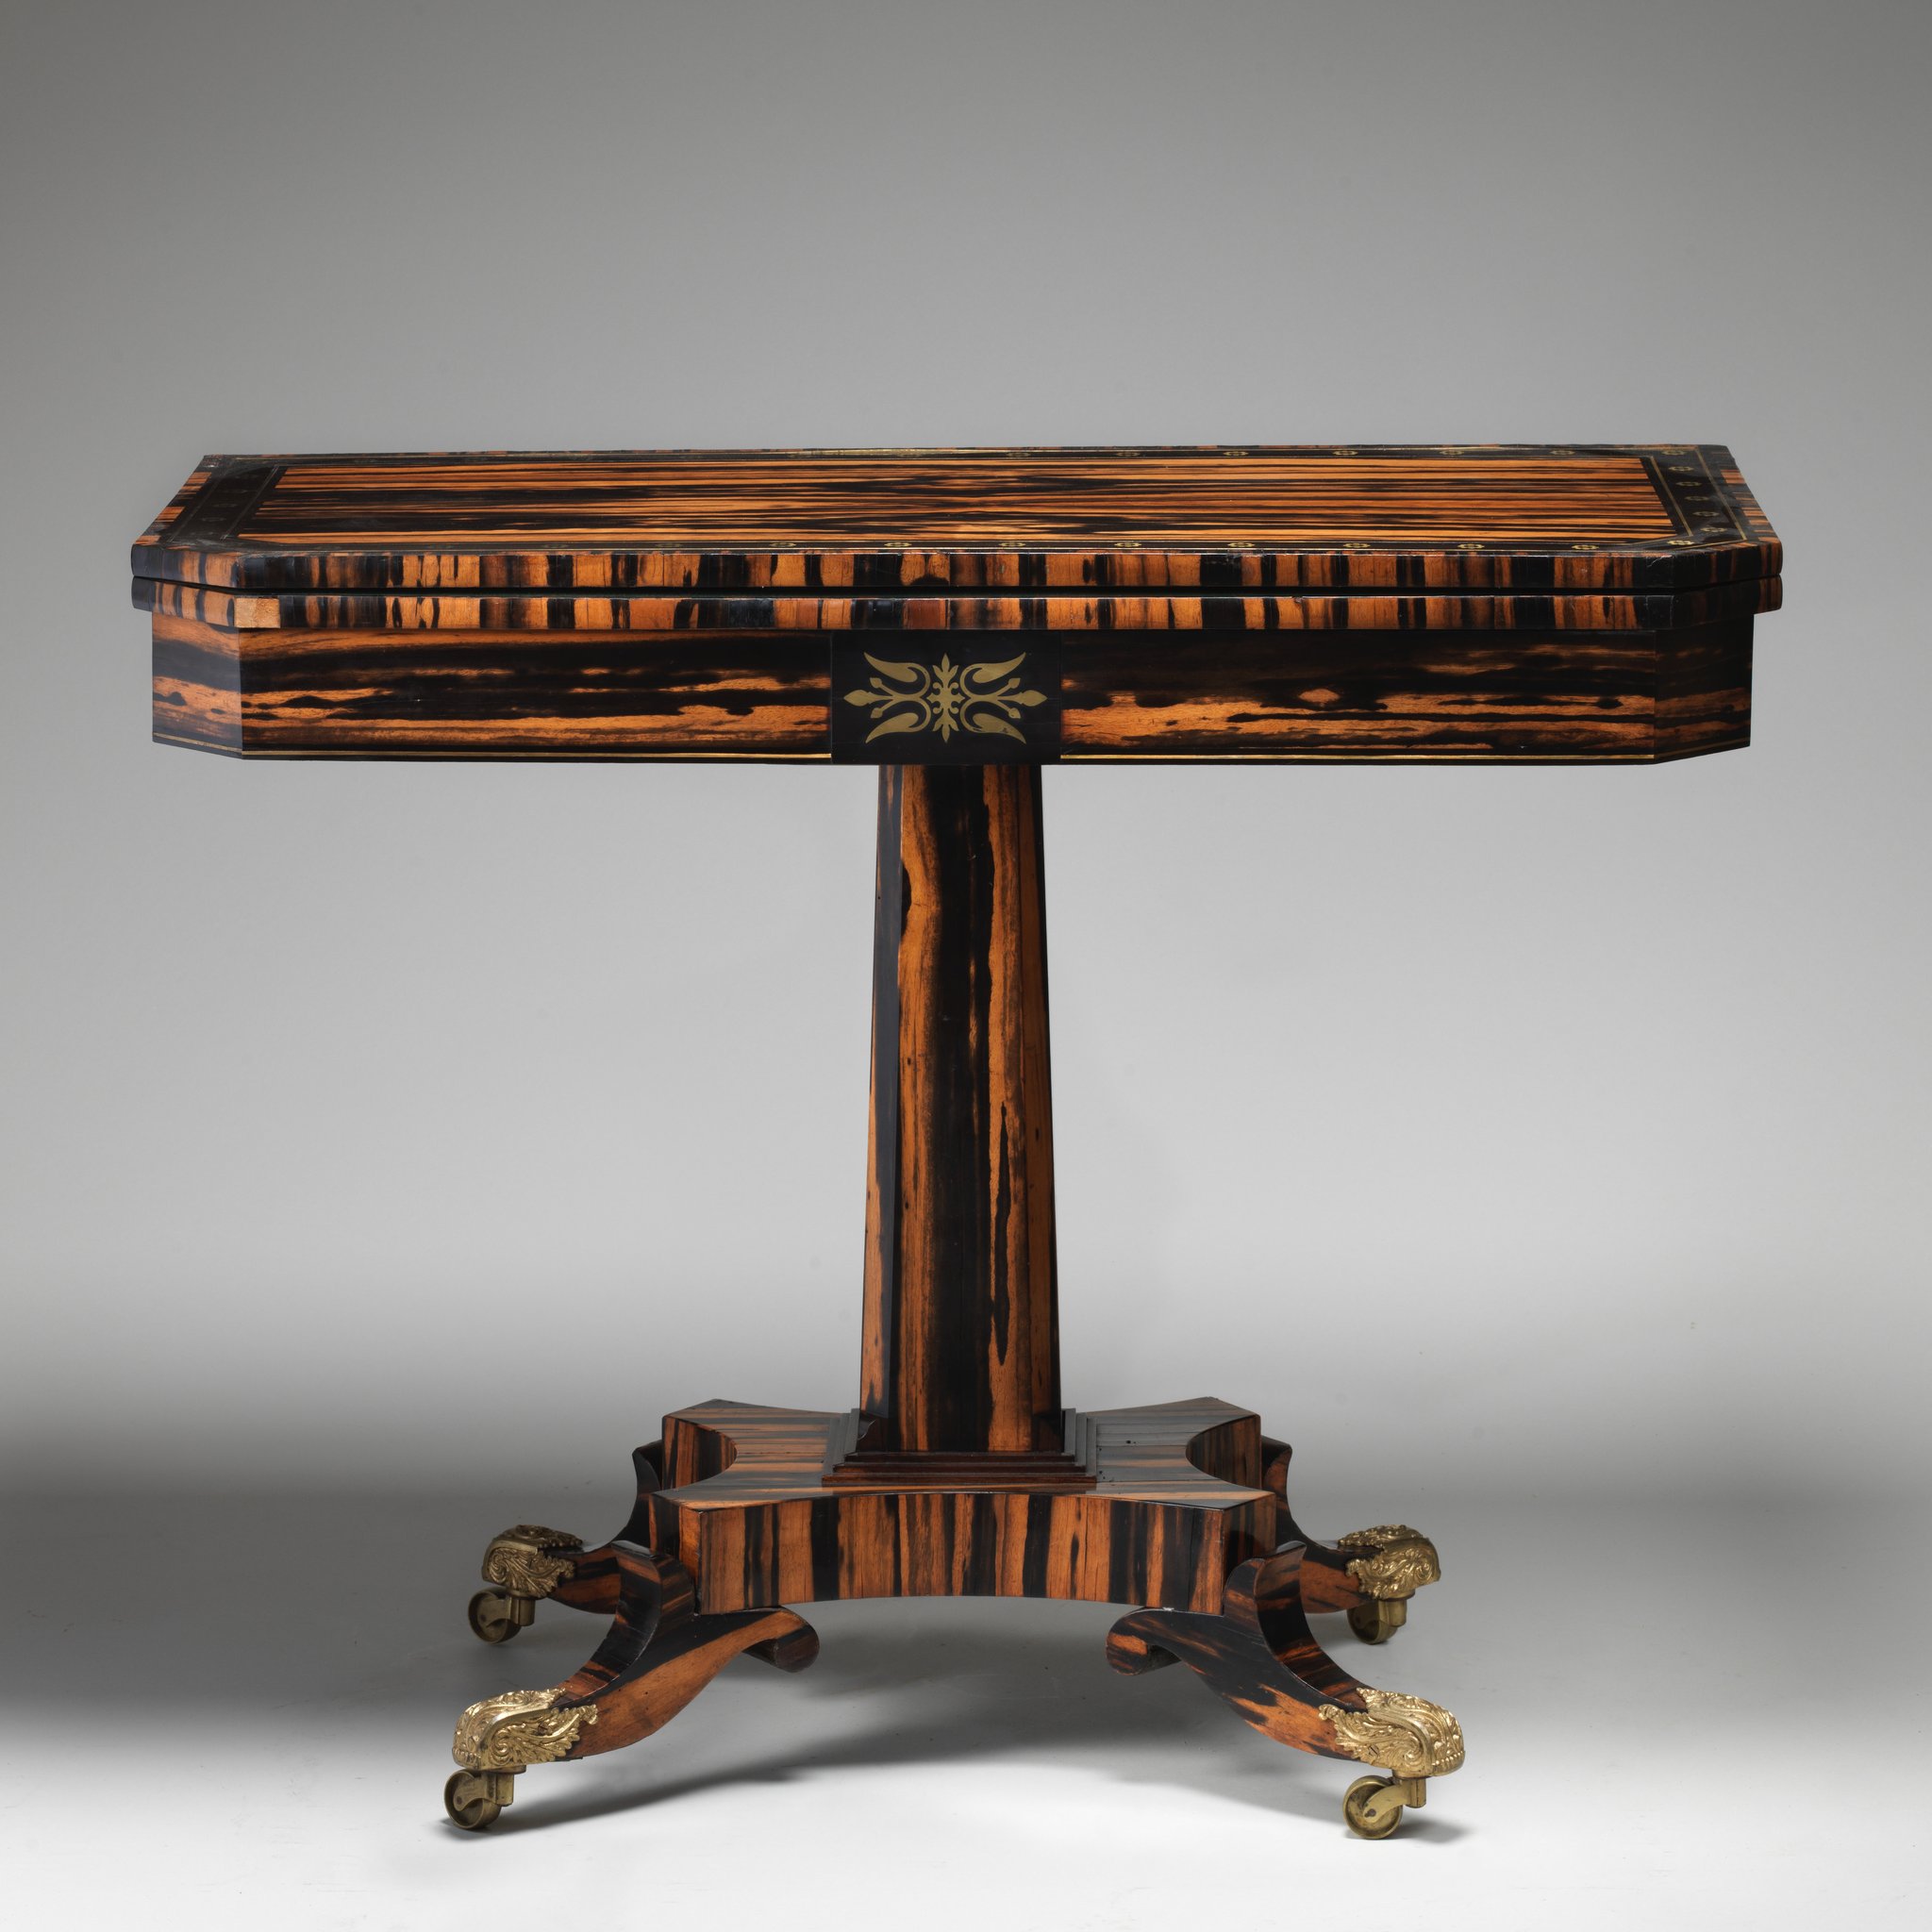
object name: card table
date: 1810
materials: brass, wood, gilt bronze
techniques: veneering